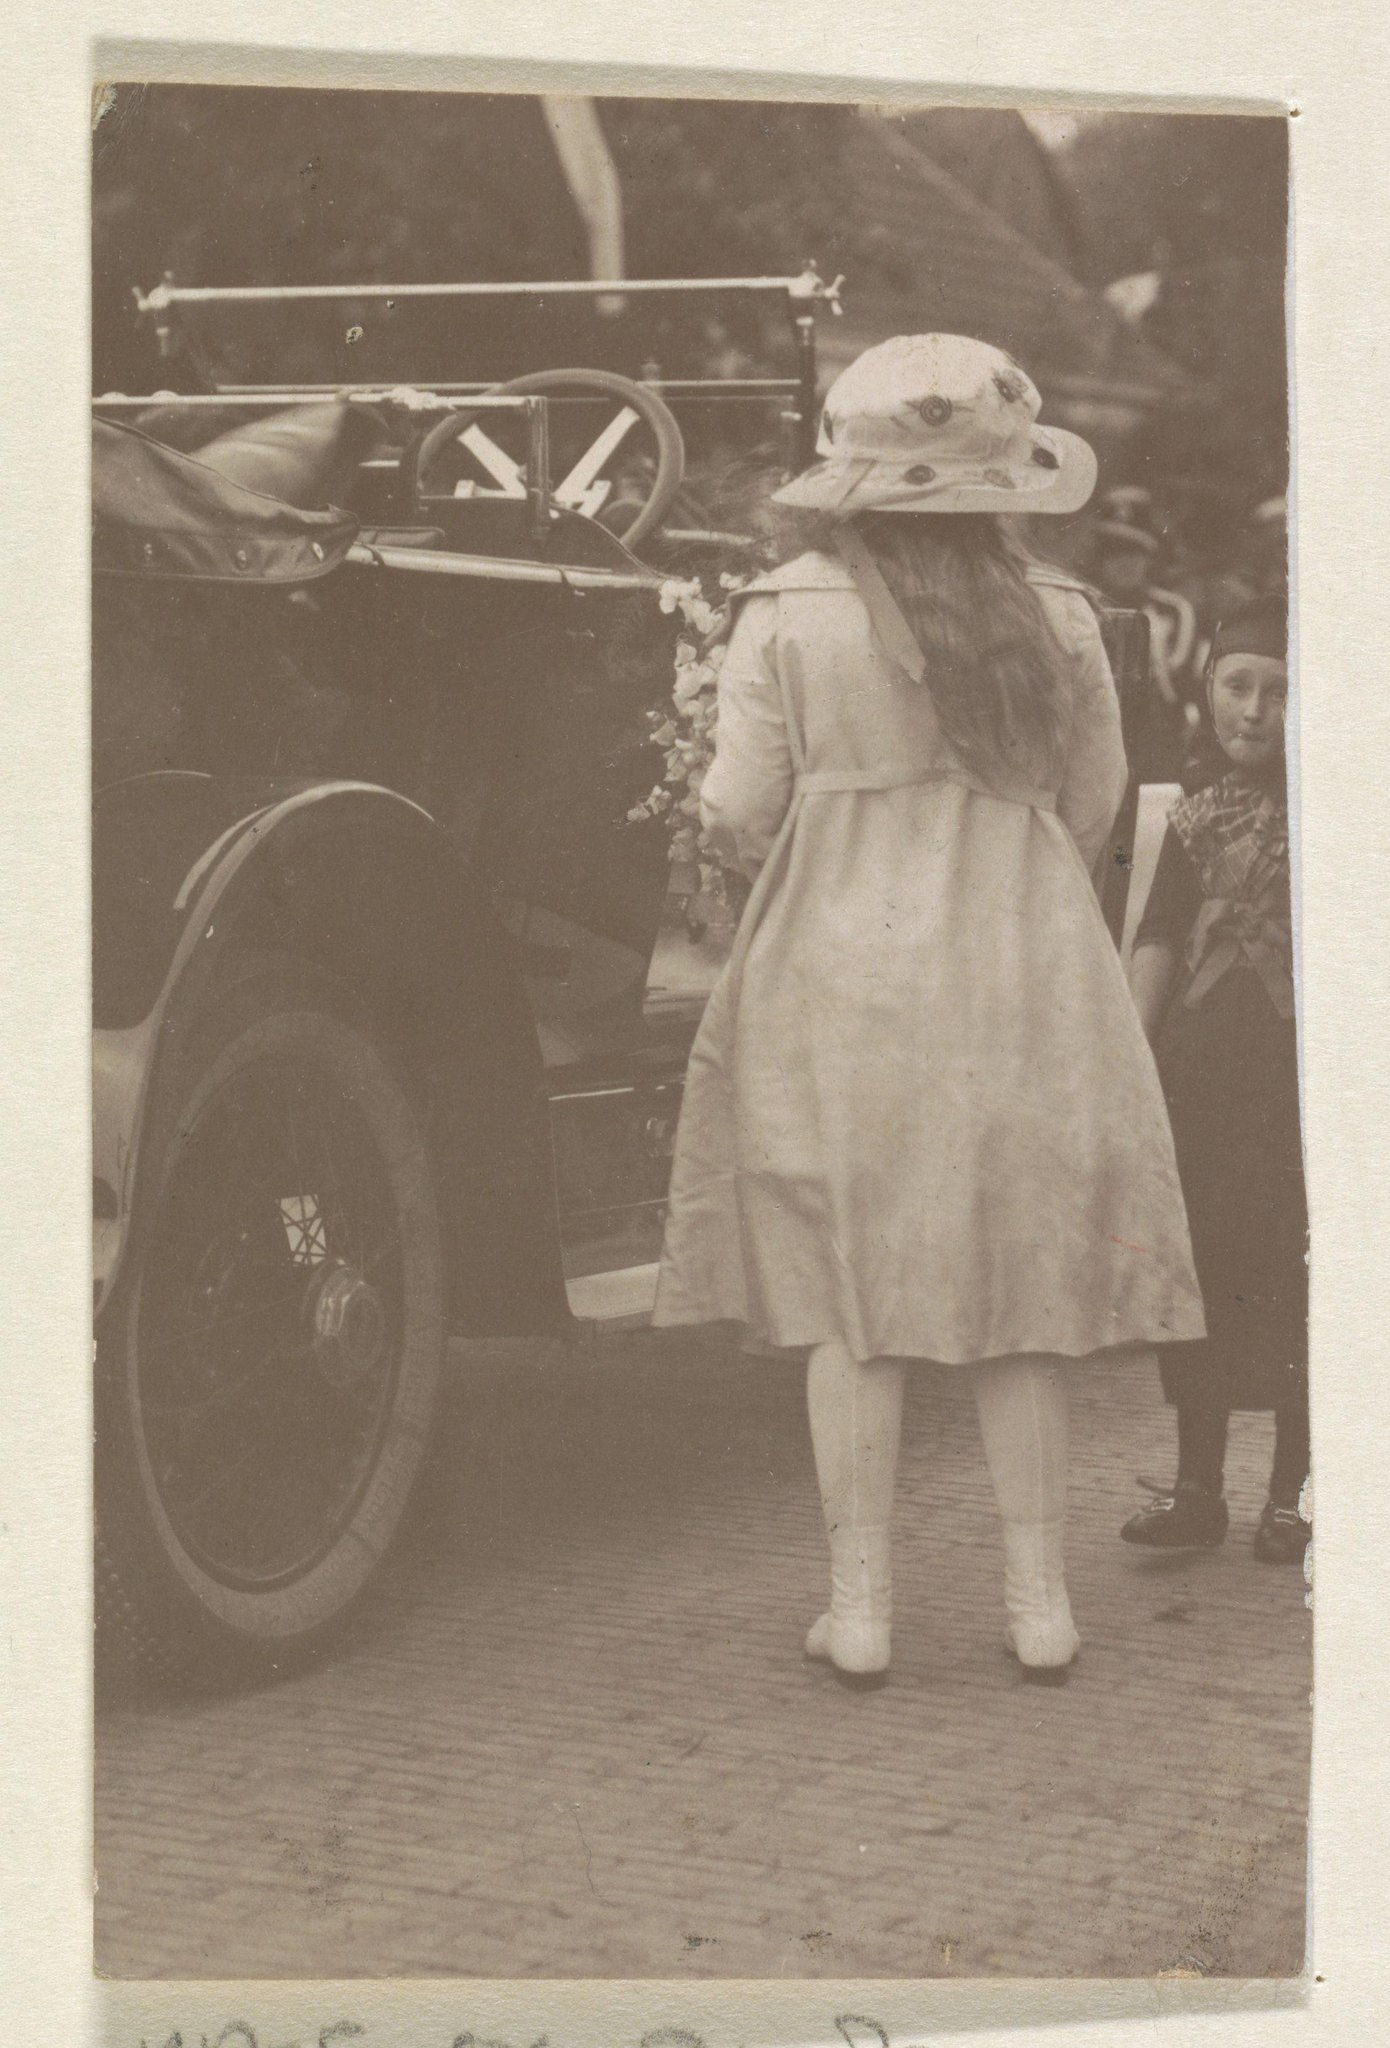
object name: ansichtkaart, prentbriefkaart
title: Prinses Juliana naast een auto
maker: Anonymous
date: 1915-1925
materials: photographic support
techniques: photography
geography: netherlands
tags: the hague, juliana of the netherlands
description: De hier vermelde titel verwijst naar de hoogst verkregen titel van de geportretteerde, niet per se naar de titel die de geportretteerde op deze voorstelling draagt.